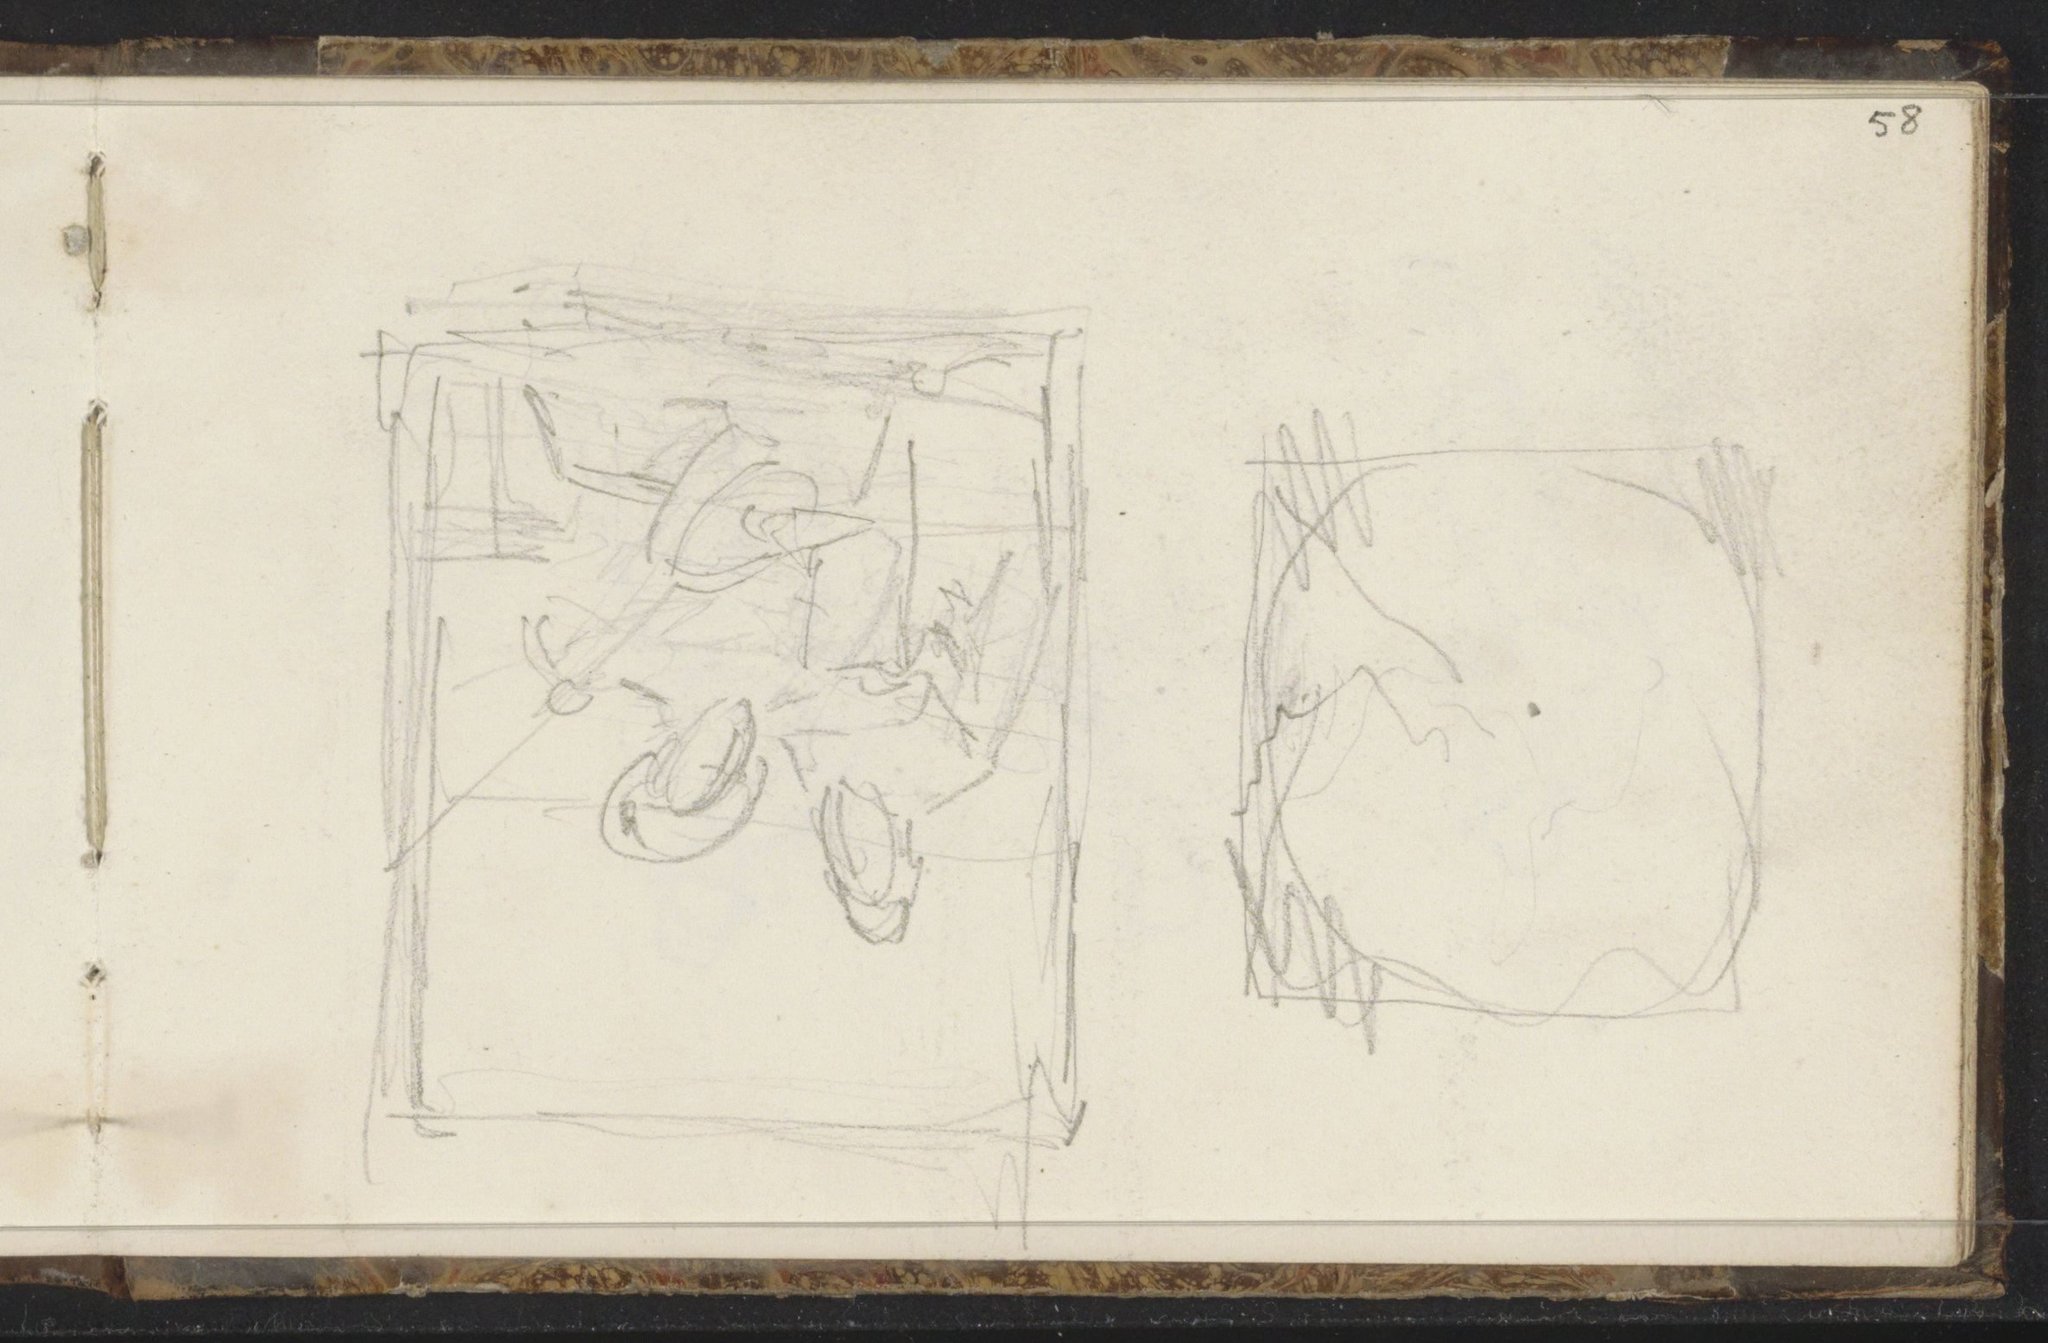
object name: sketchbook leaf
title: Luitspeler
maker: willem hendrik schmidt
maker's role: draughtsman, painter, print maker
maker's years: 1809-1849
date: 1819-1849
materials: paper, pencil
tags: lute, and special forms of lute, e.g.: theorbo (+ artist at work)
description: Schets in een kader. Tevens een studie. Blad 58 recto uit een schetsboek met 60 bladen.